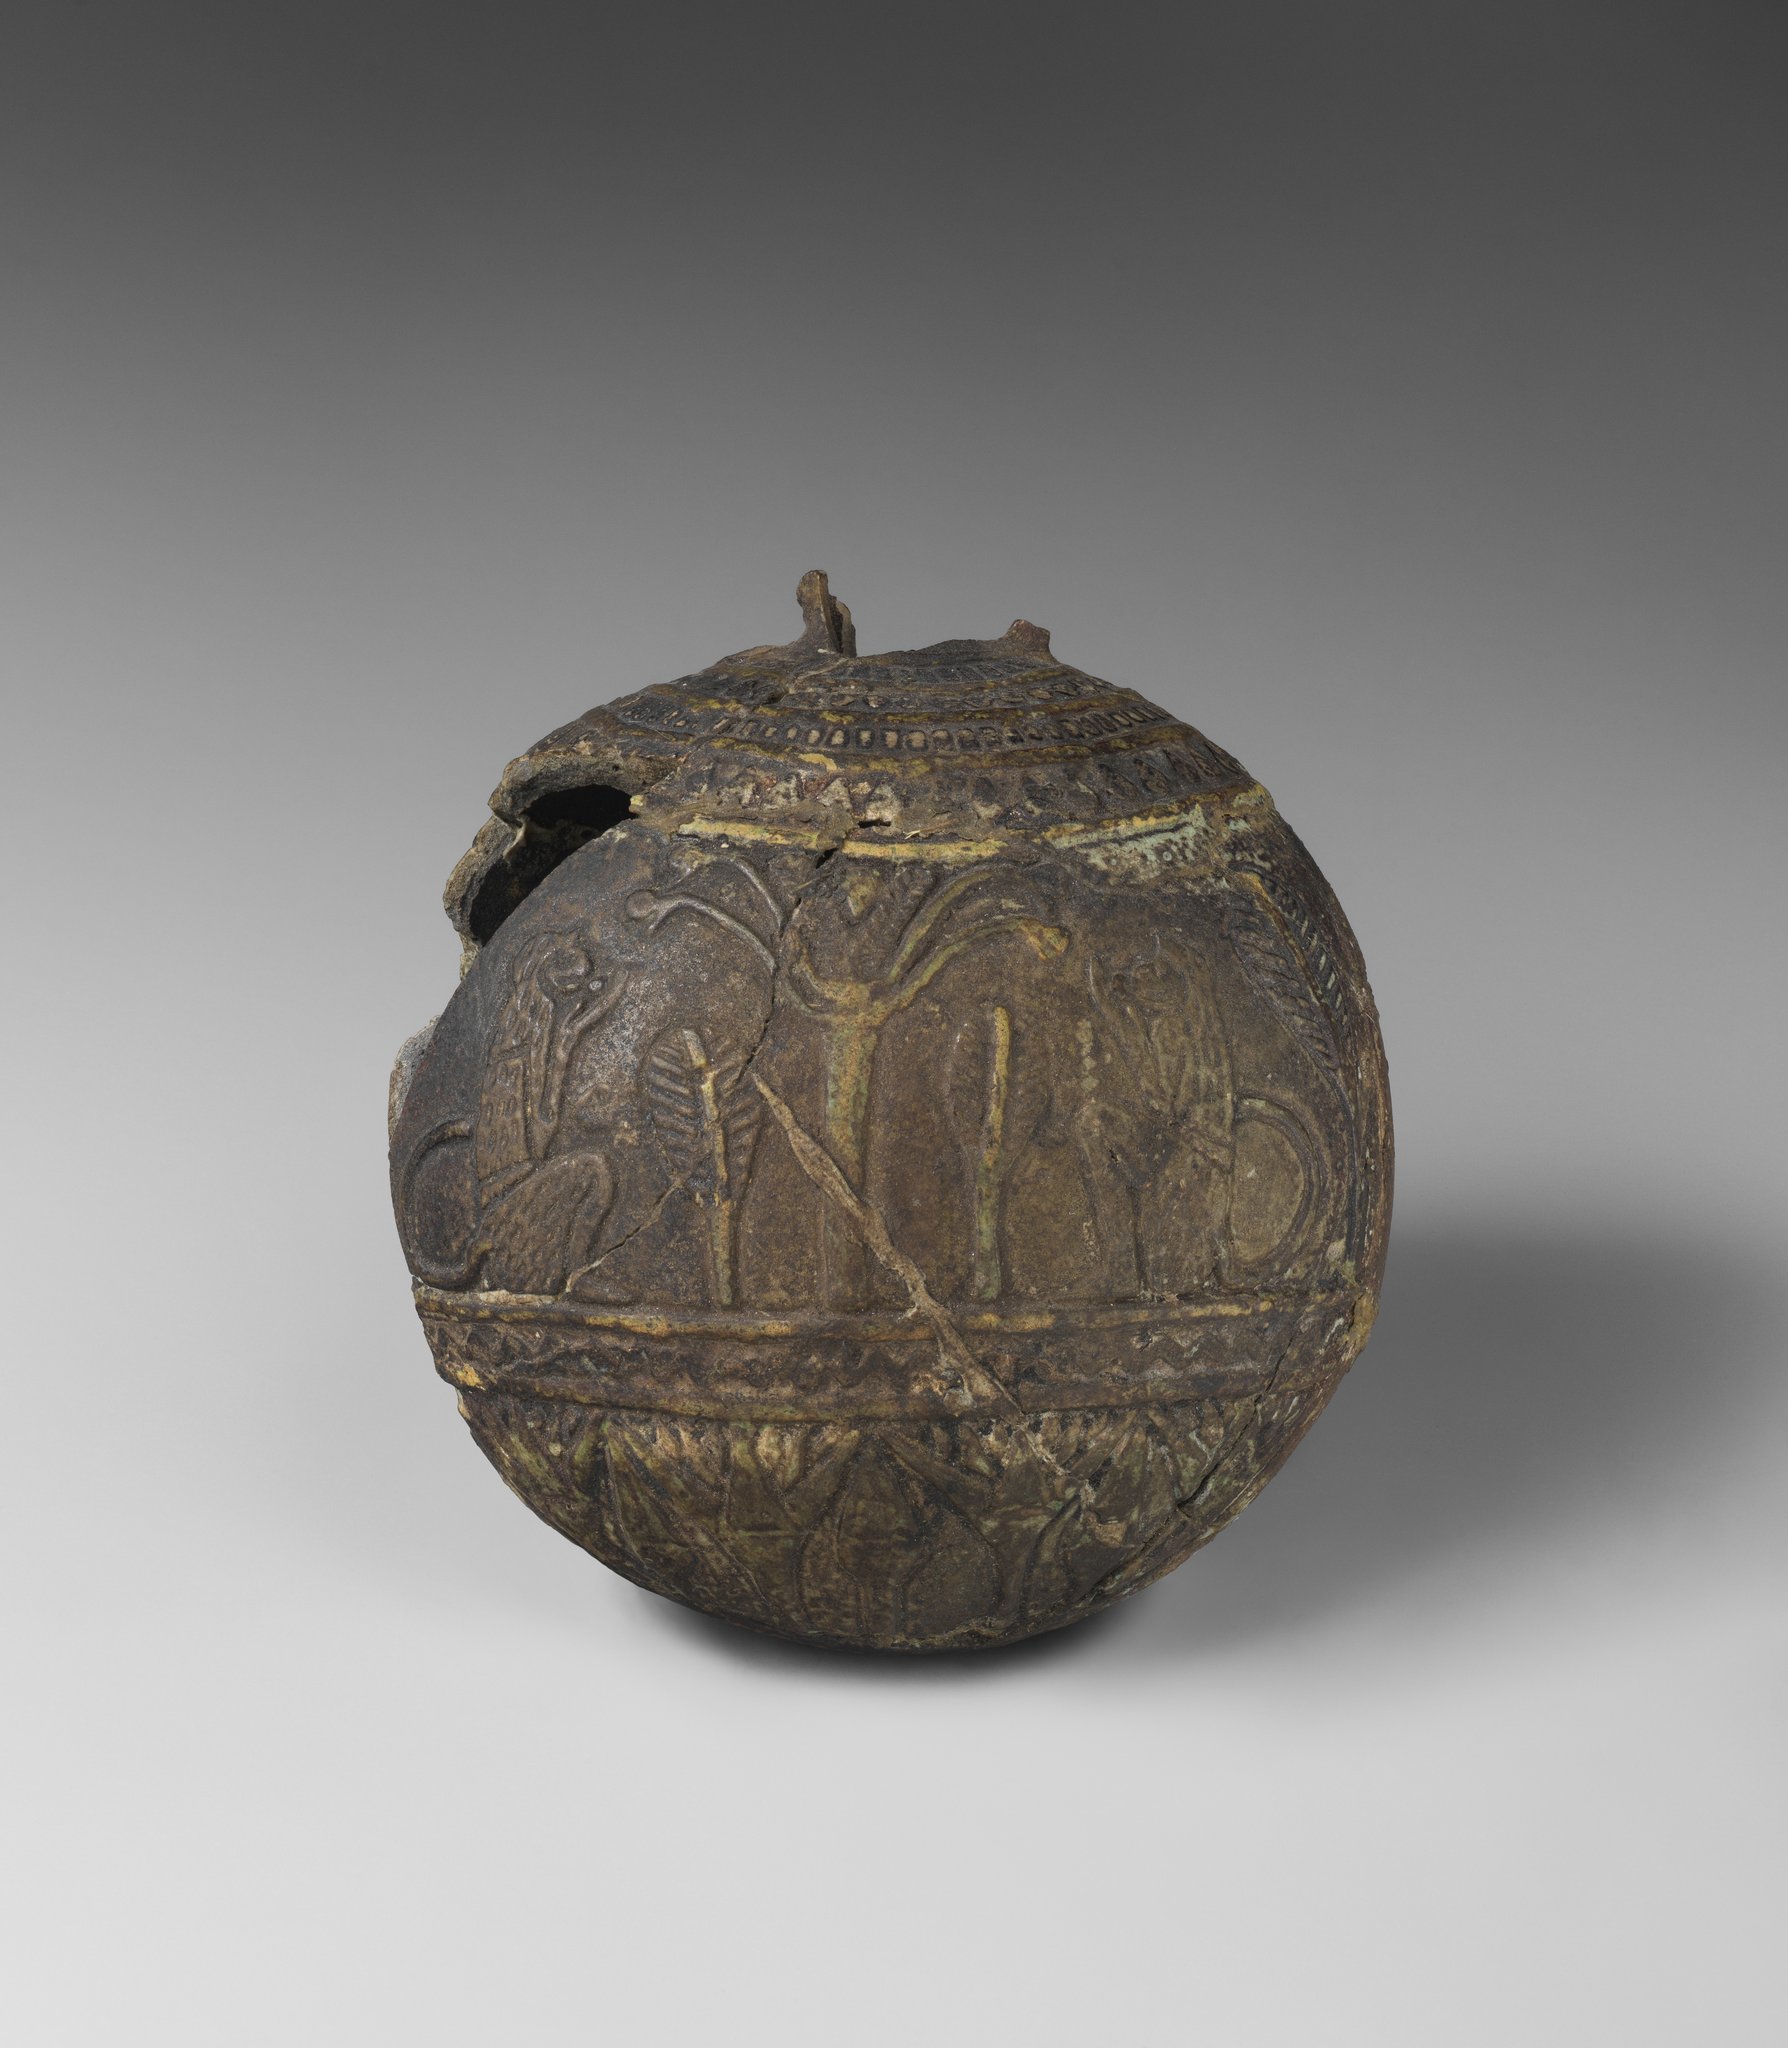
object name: lentoid bottle, new year's bottle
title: Lentoid Bottle ("New Year's Bottle")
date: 630 BCE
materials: faience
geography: egypt